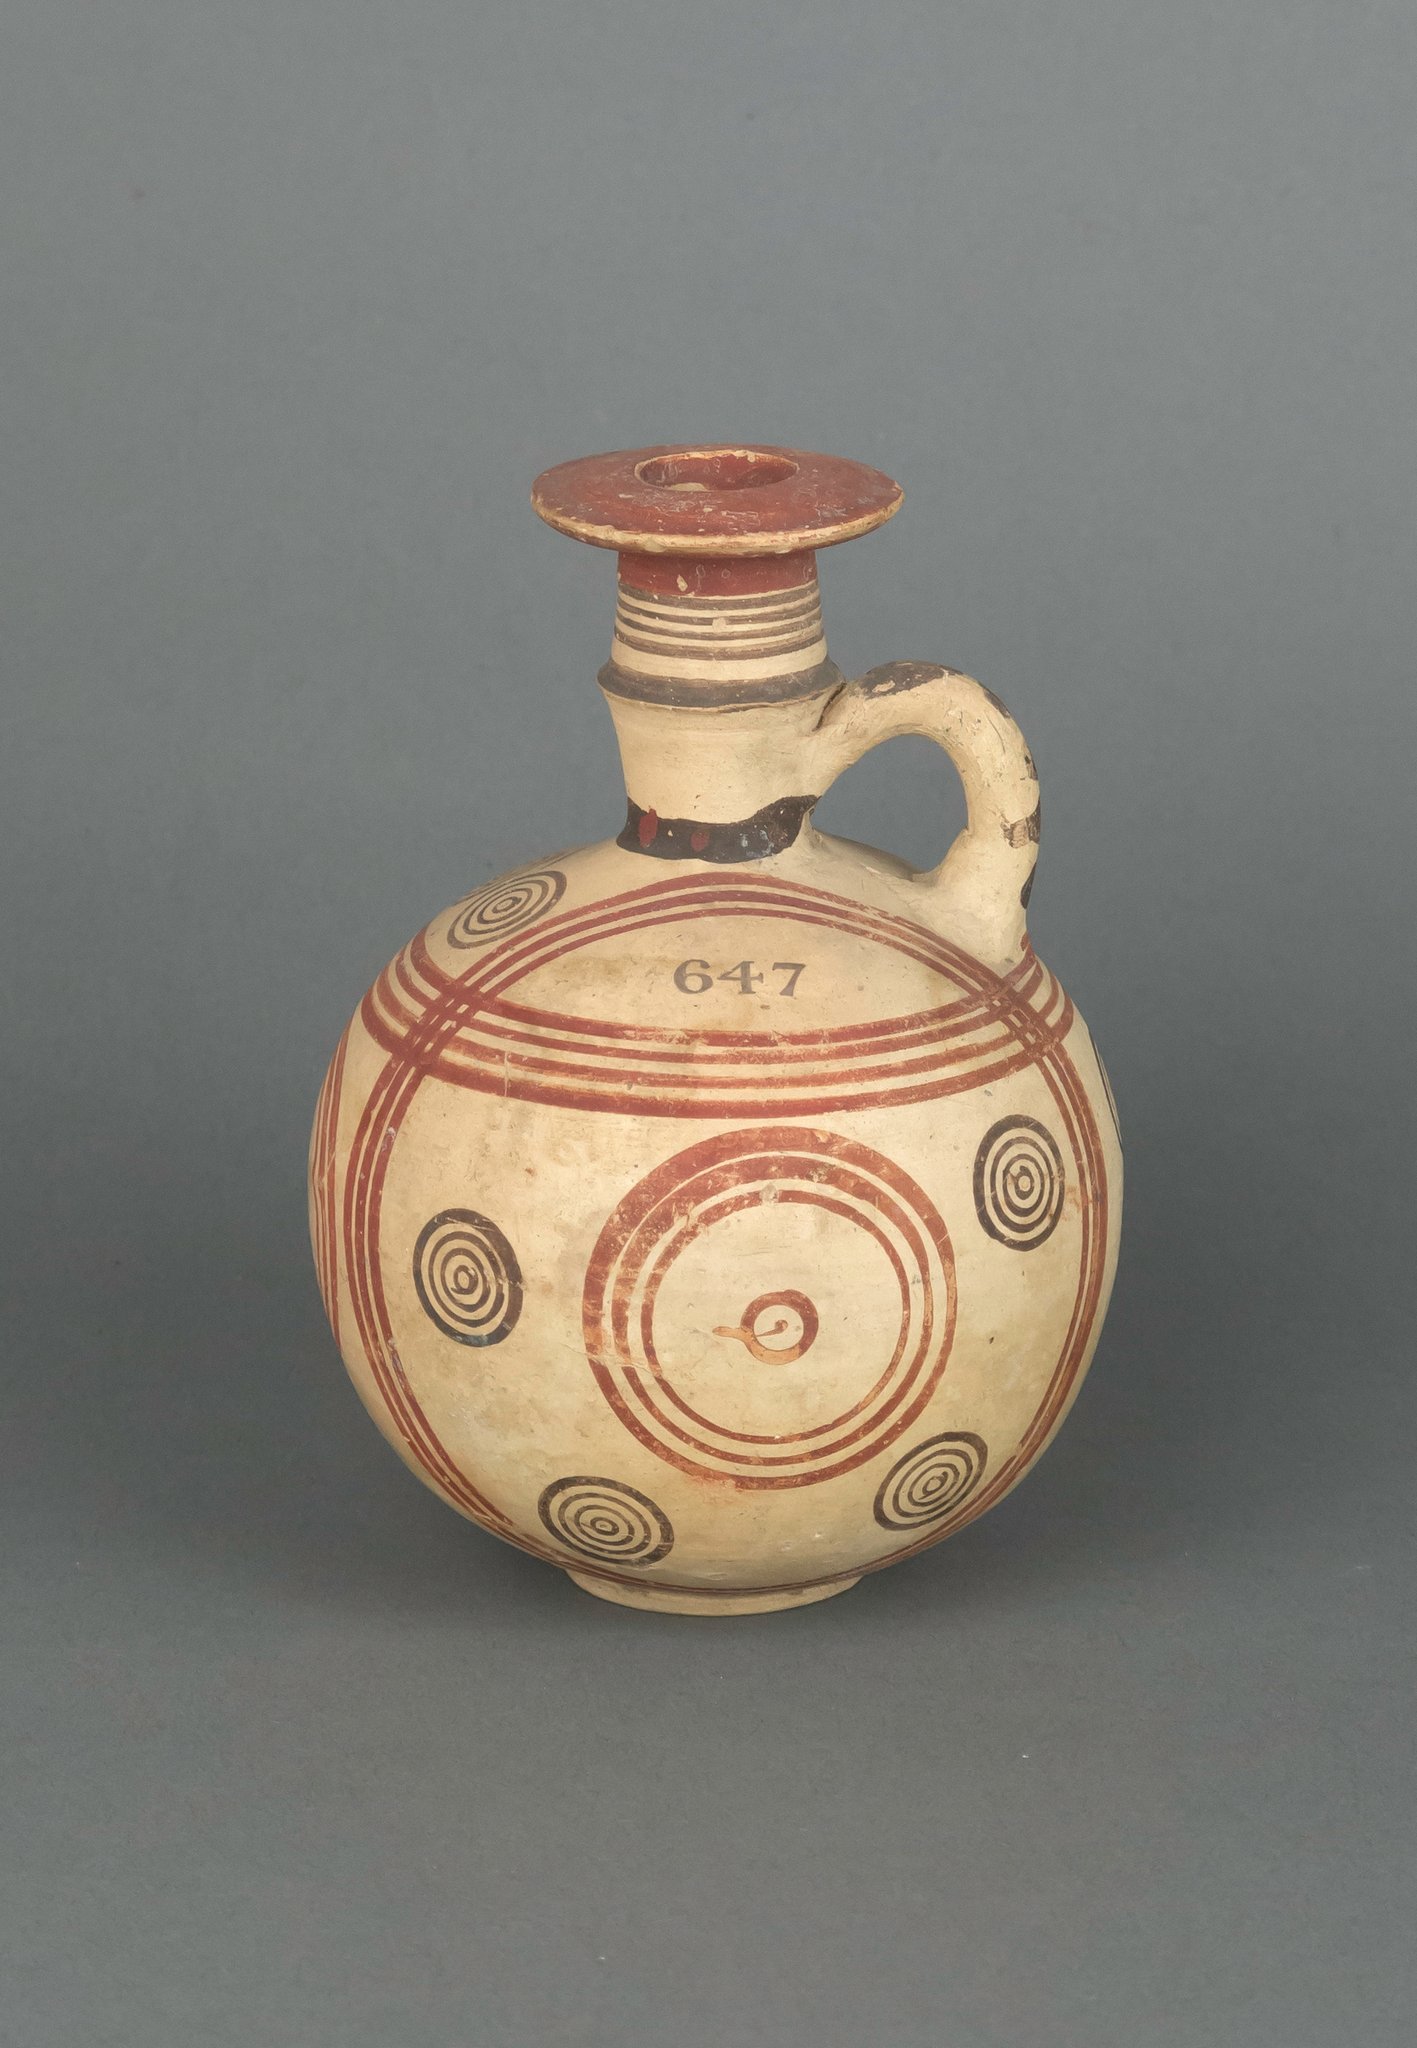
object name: juglet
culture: cypriot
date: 750-600 BCE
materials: terracotta